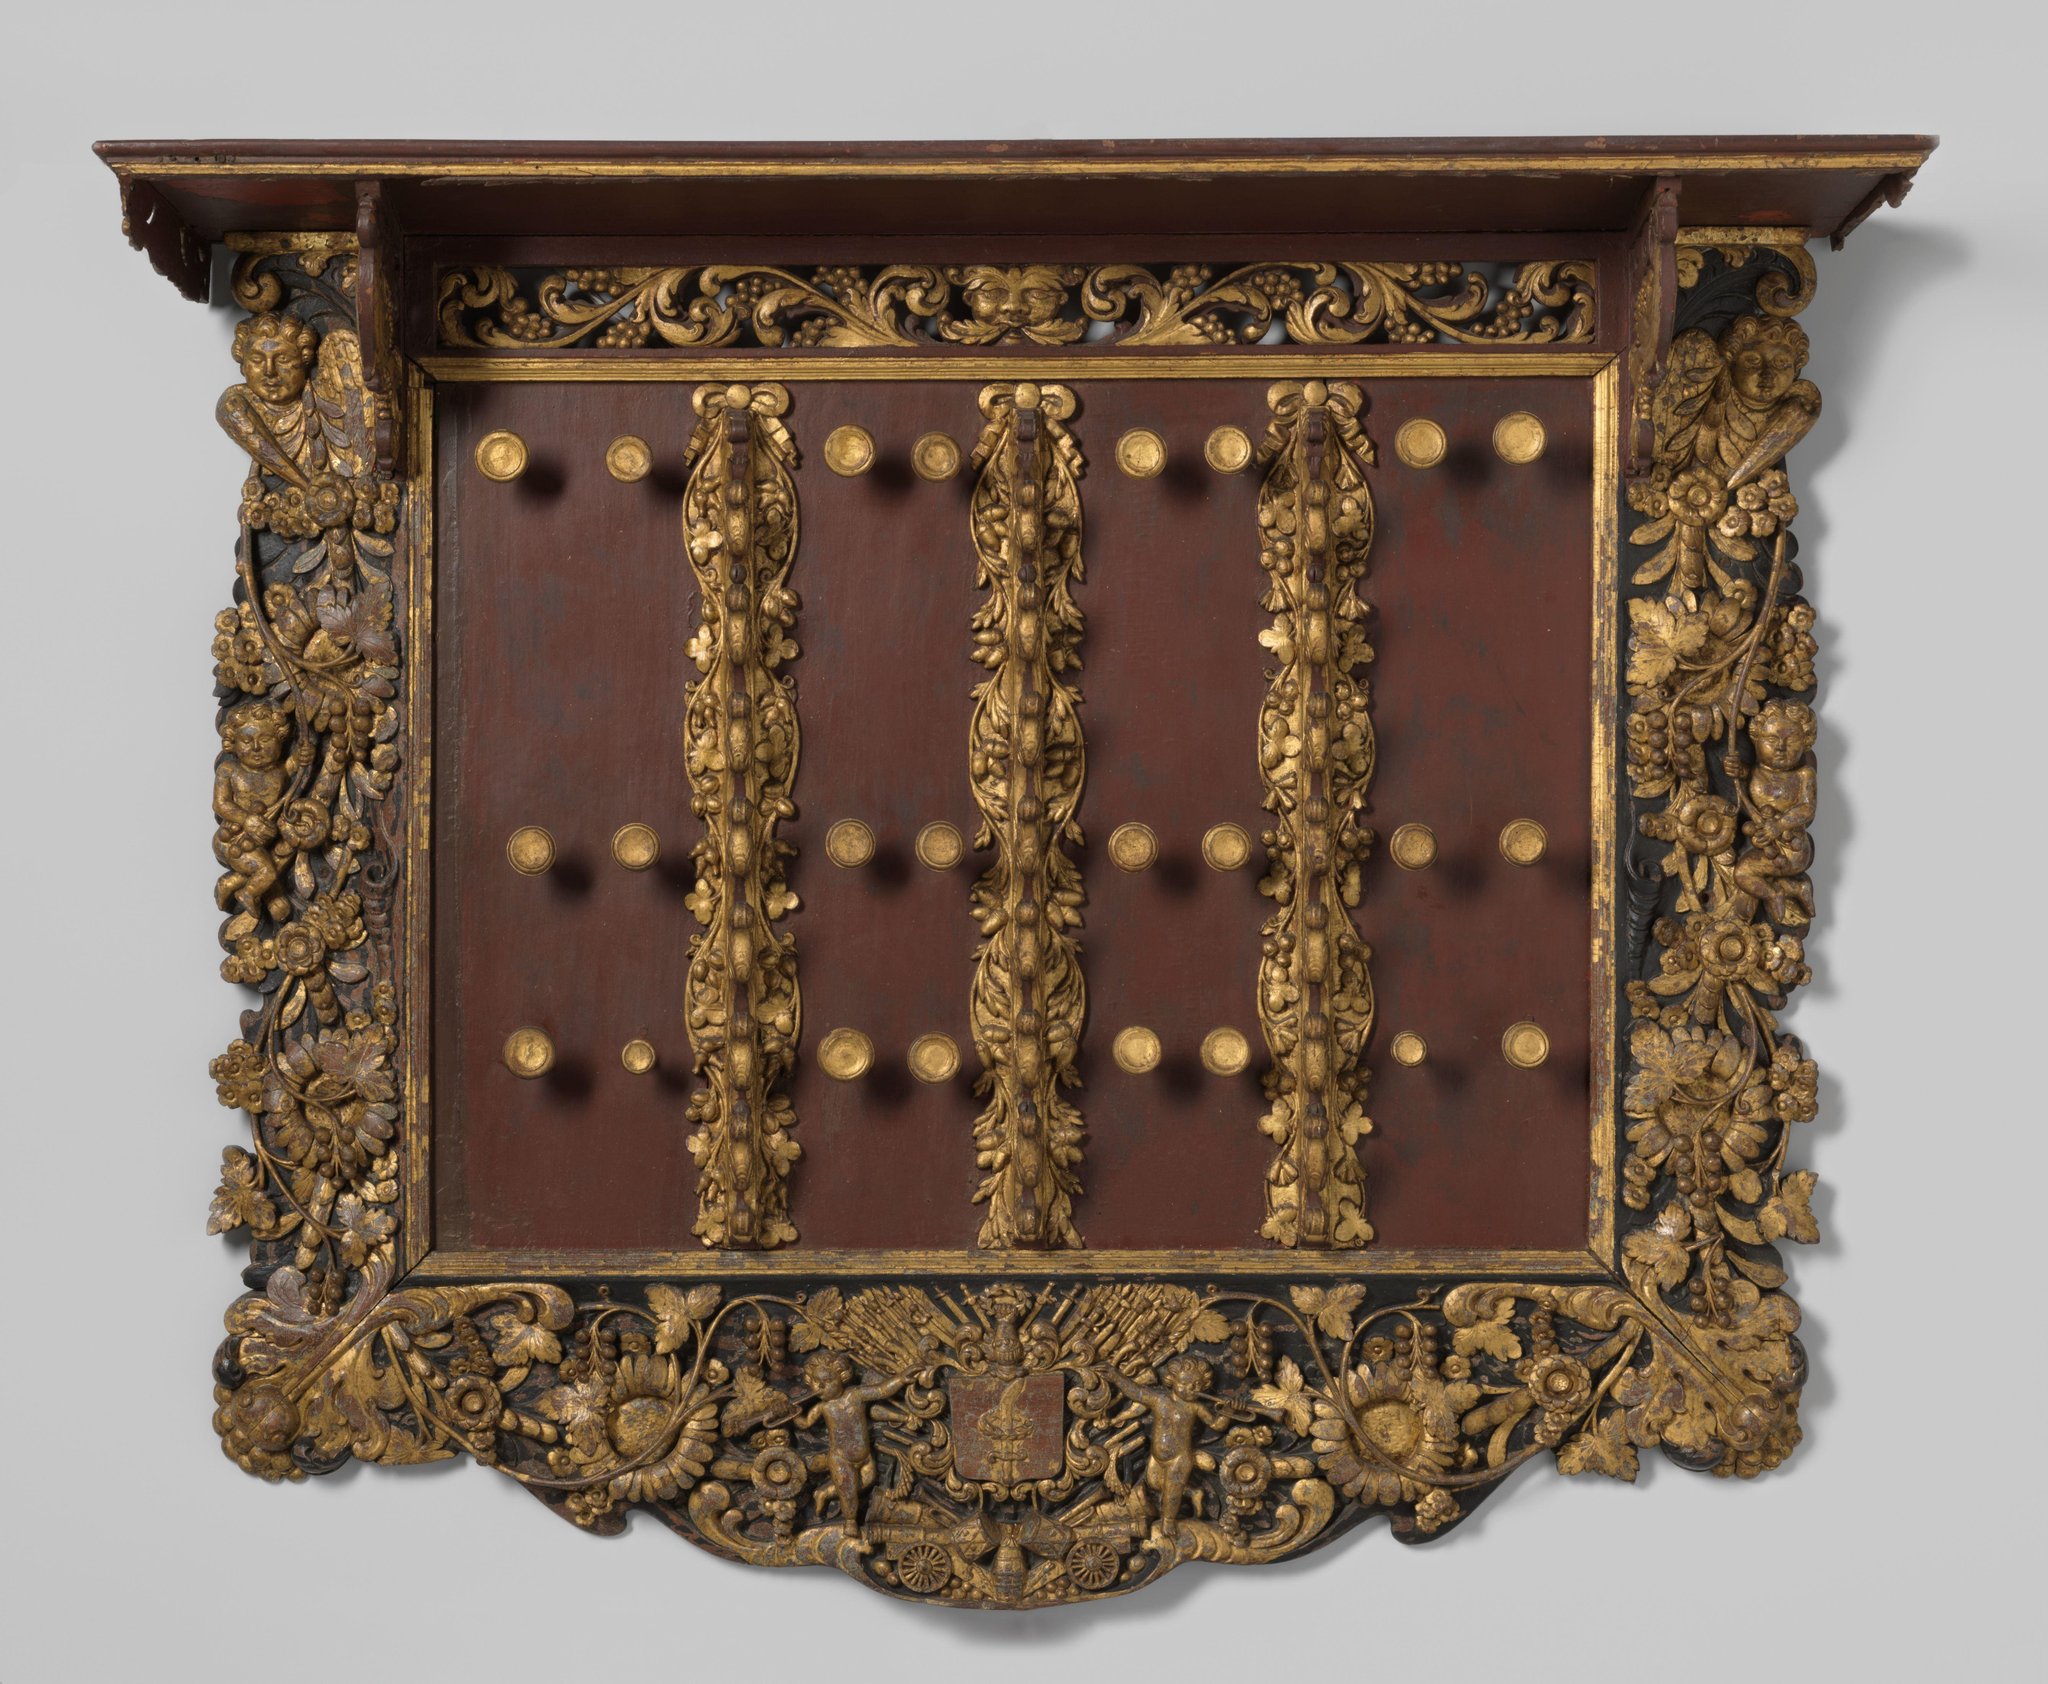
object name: arm rack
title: Wapenrek, gesneden, gekleurd en gedeeltelijk verguld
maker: Anonymous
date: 1680-1720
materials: wood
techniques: gilding, painted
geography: indonesia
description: Wapenrek van deels verguld en deels rood beschilderd teakhout. Het rode paneel met vergulde haken en steunen voor de wapens wordt omgeven door een brede band met bloemen en engelen. De motieven zijn in hoog relief gesneden en verguld tegen een zwarte achtergrond. Aan de onderzijde is in het relief een wapenschild verwerkt: een gebroken zwaard omgeven door een lauwerkrans. Achter het wapenschild staan speren en zwaarden, eronder kanonnen.